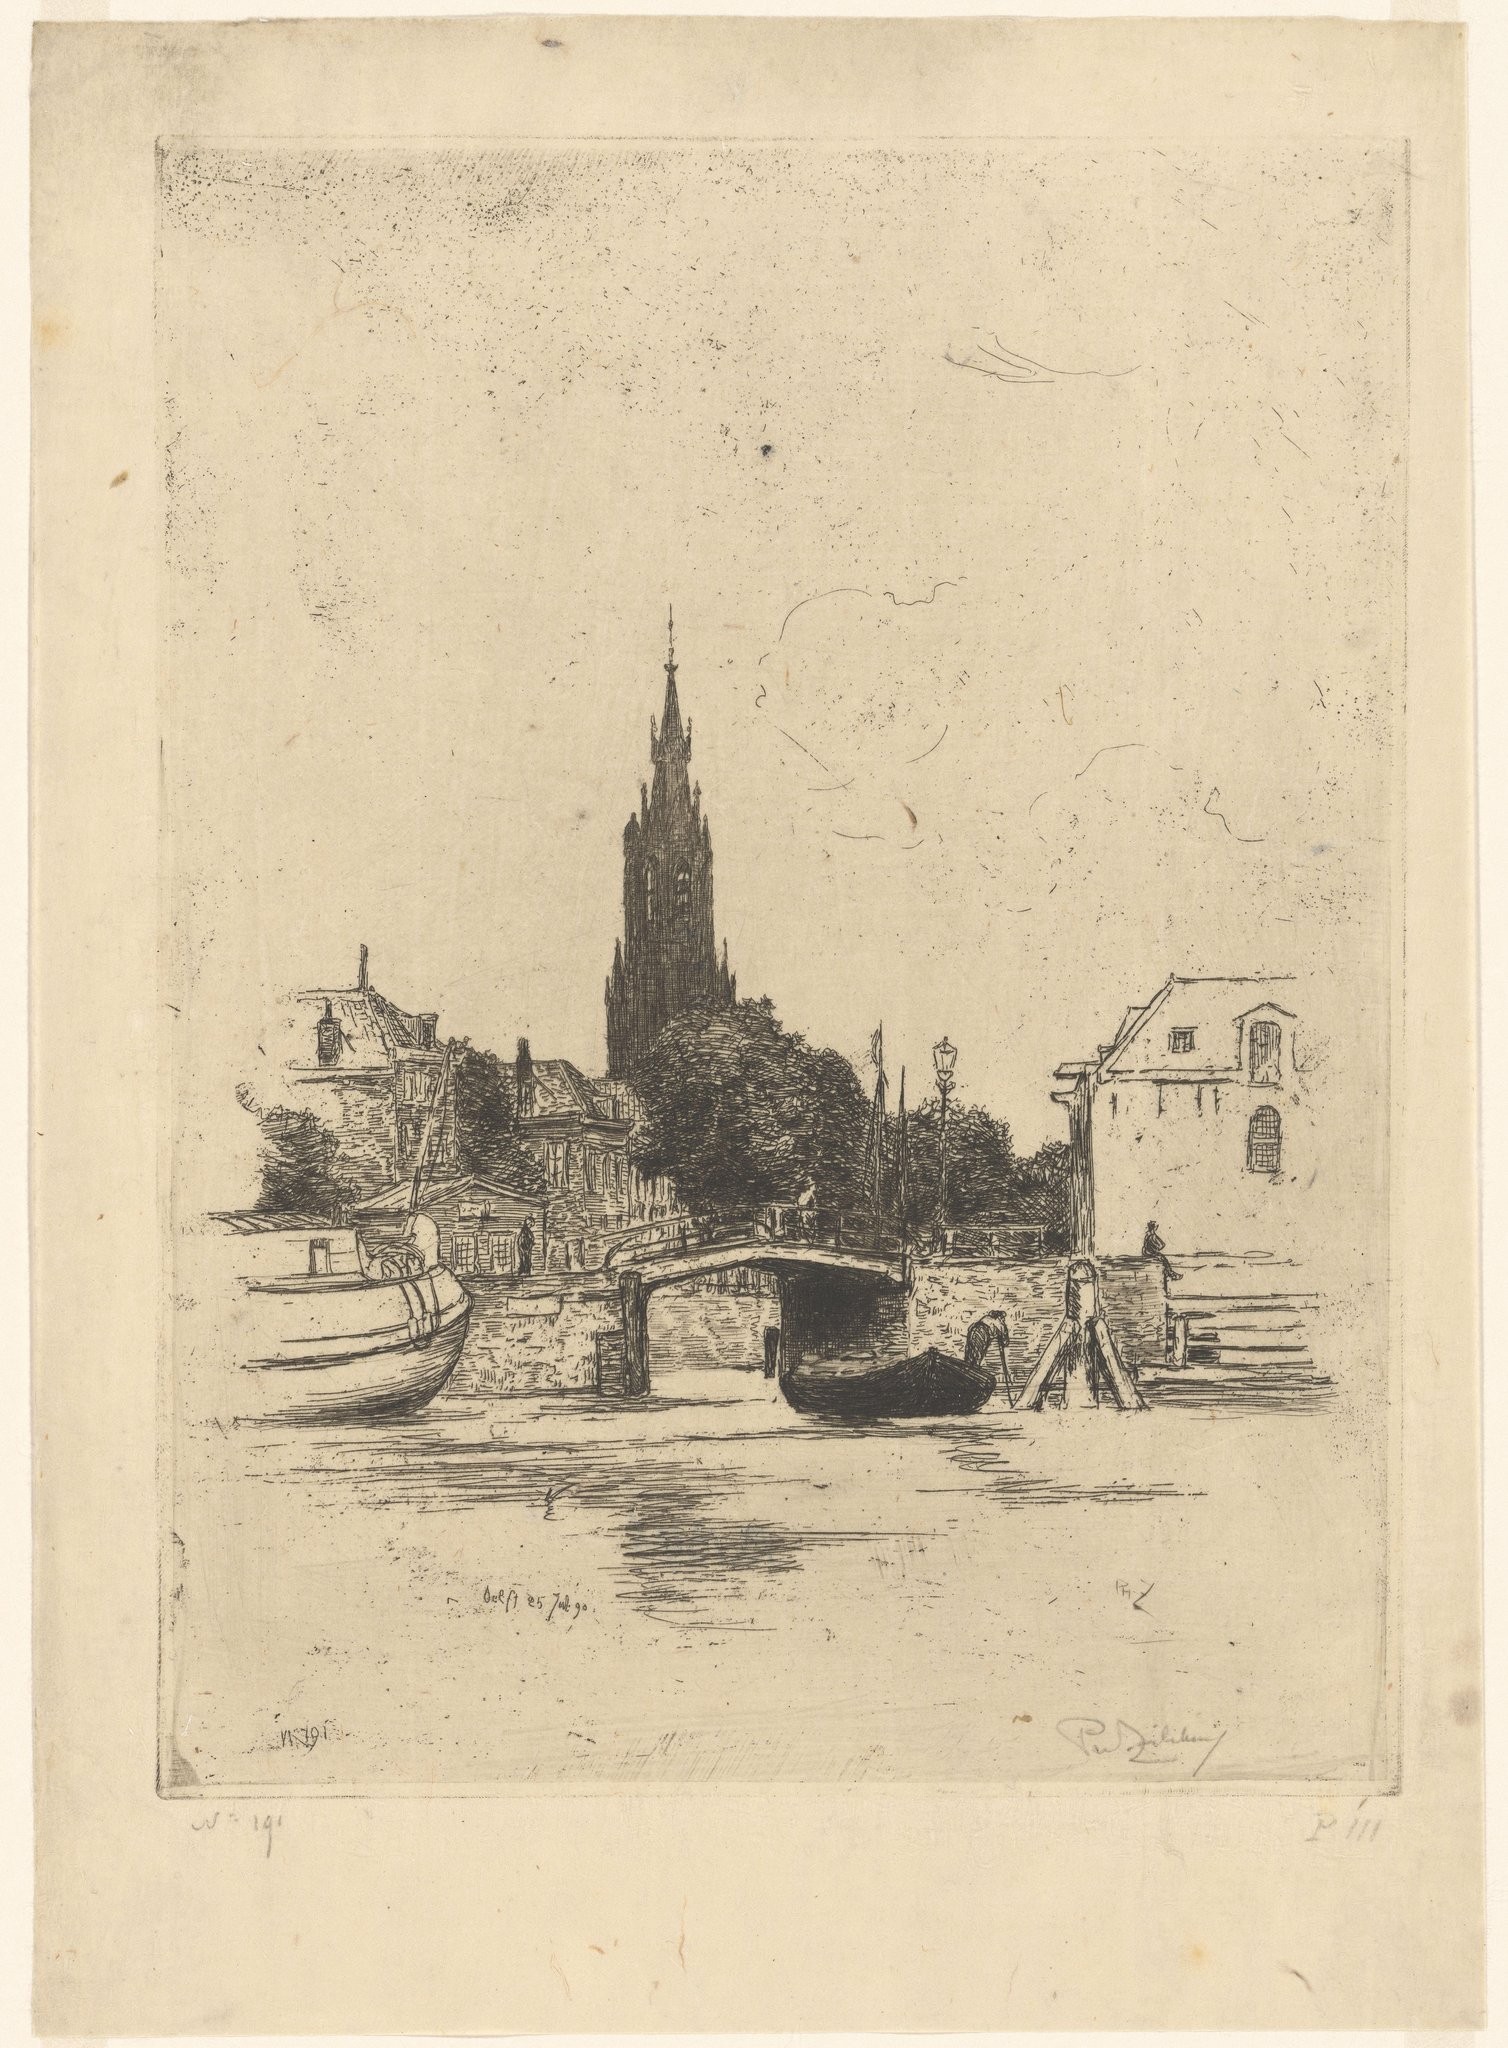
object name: print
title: Gezicht op het Mallegat, te Delft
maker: philip zilcken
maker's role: draughtsman, painter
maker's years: 1857-1930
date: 1890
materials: paper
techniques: drypoint, etching, intaglio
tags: church (exterior), canals, waters (in city), bridge, delft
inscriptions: date